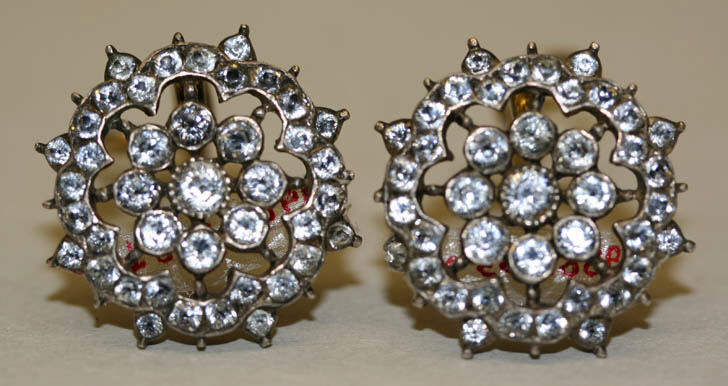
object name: earring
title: Earrings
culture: european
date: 1760-1775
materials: metal, paste